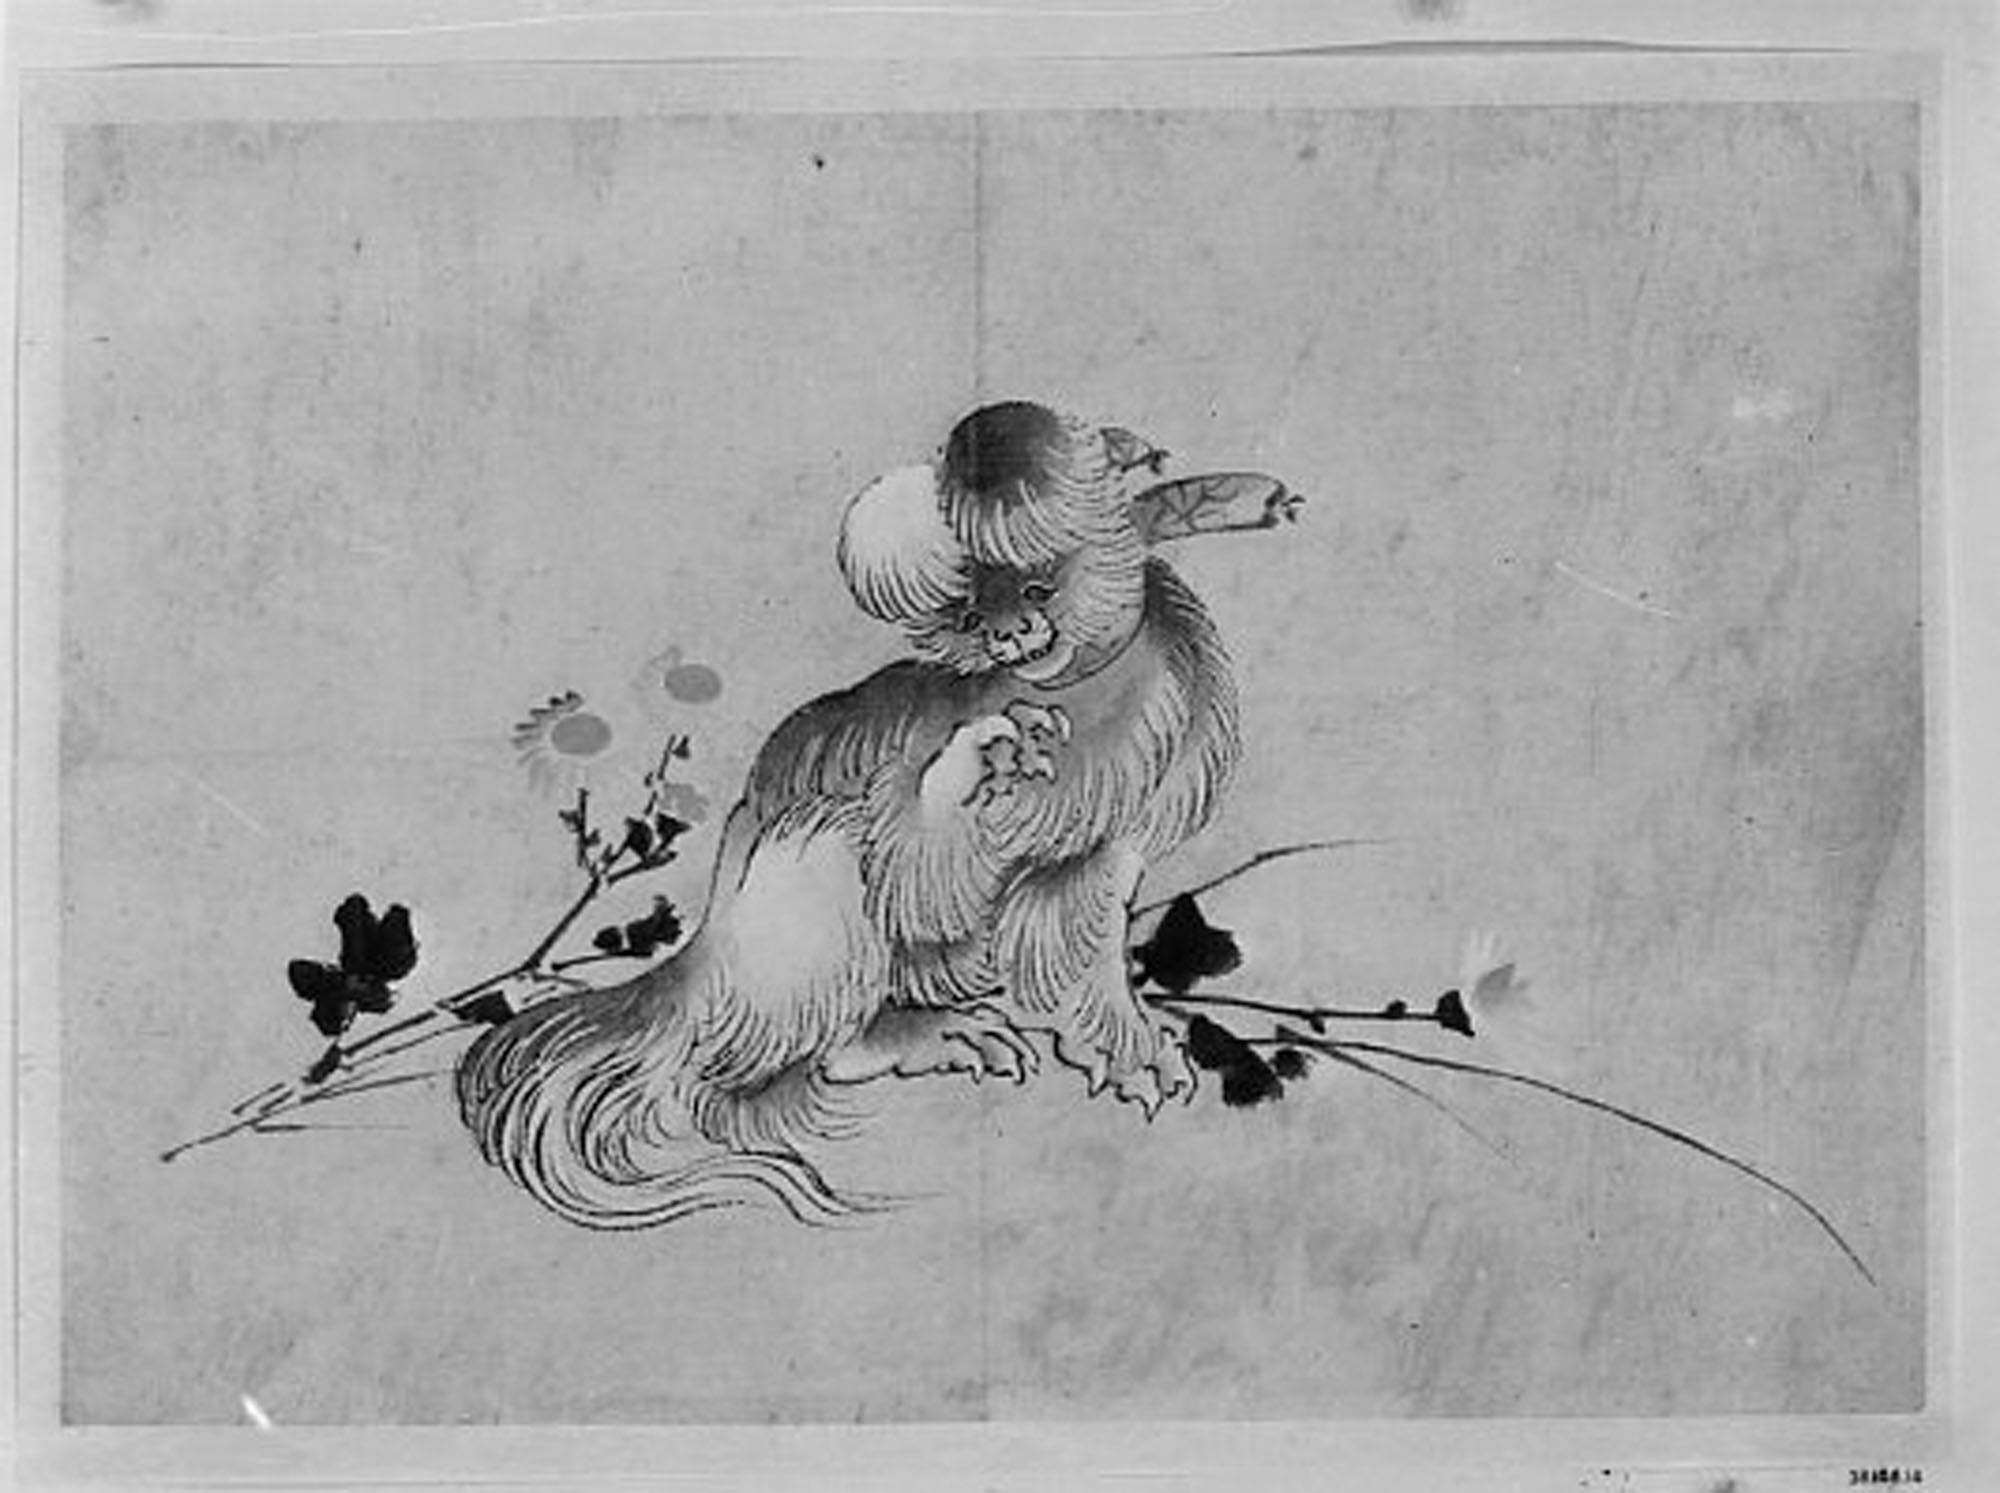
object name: painting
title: Pekingese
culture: japanese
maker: hokusai school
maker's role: artist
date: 1801-1900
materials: ink, paper, watercolor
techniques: painting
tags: dogs,flowers